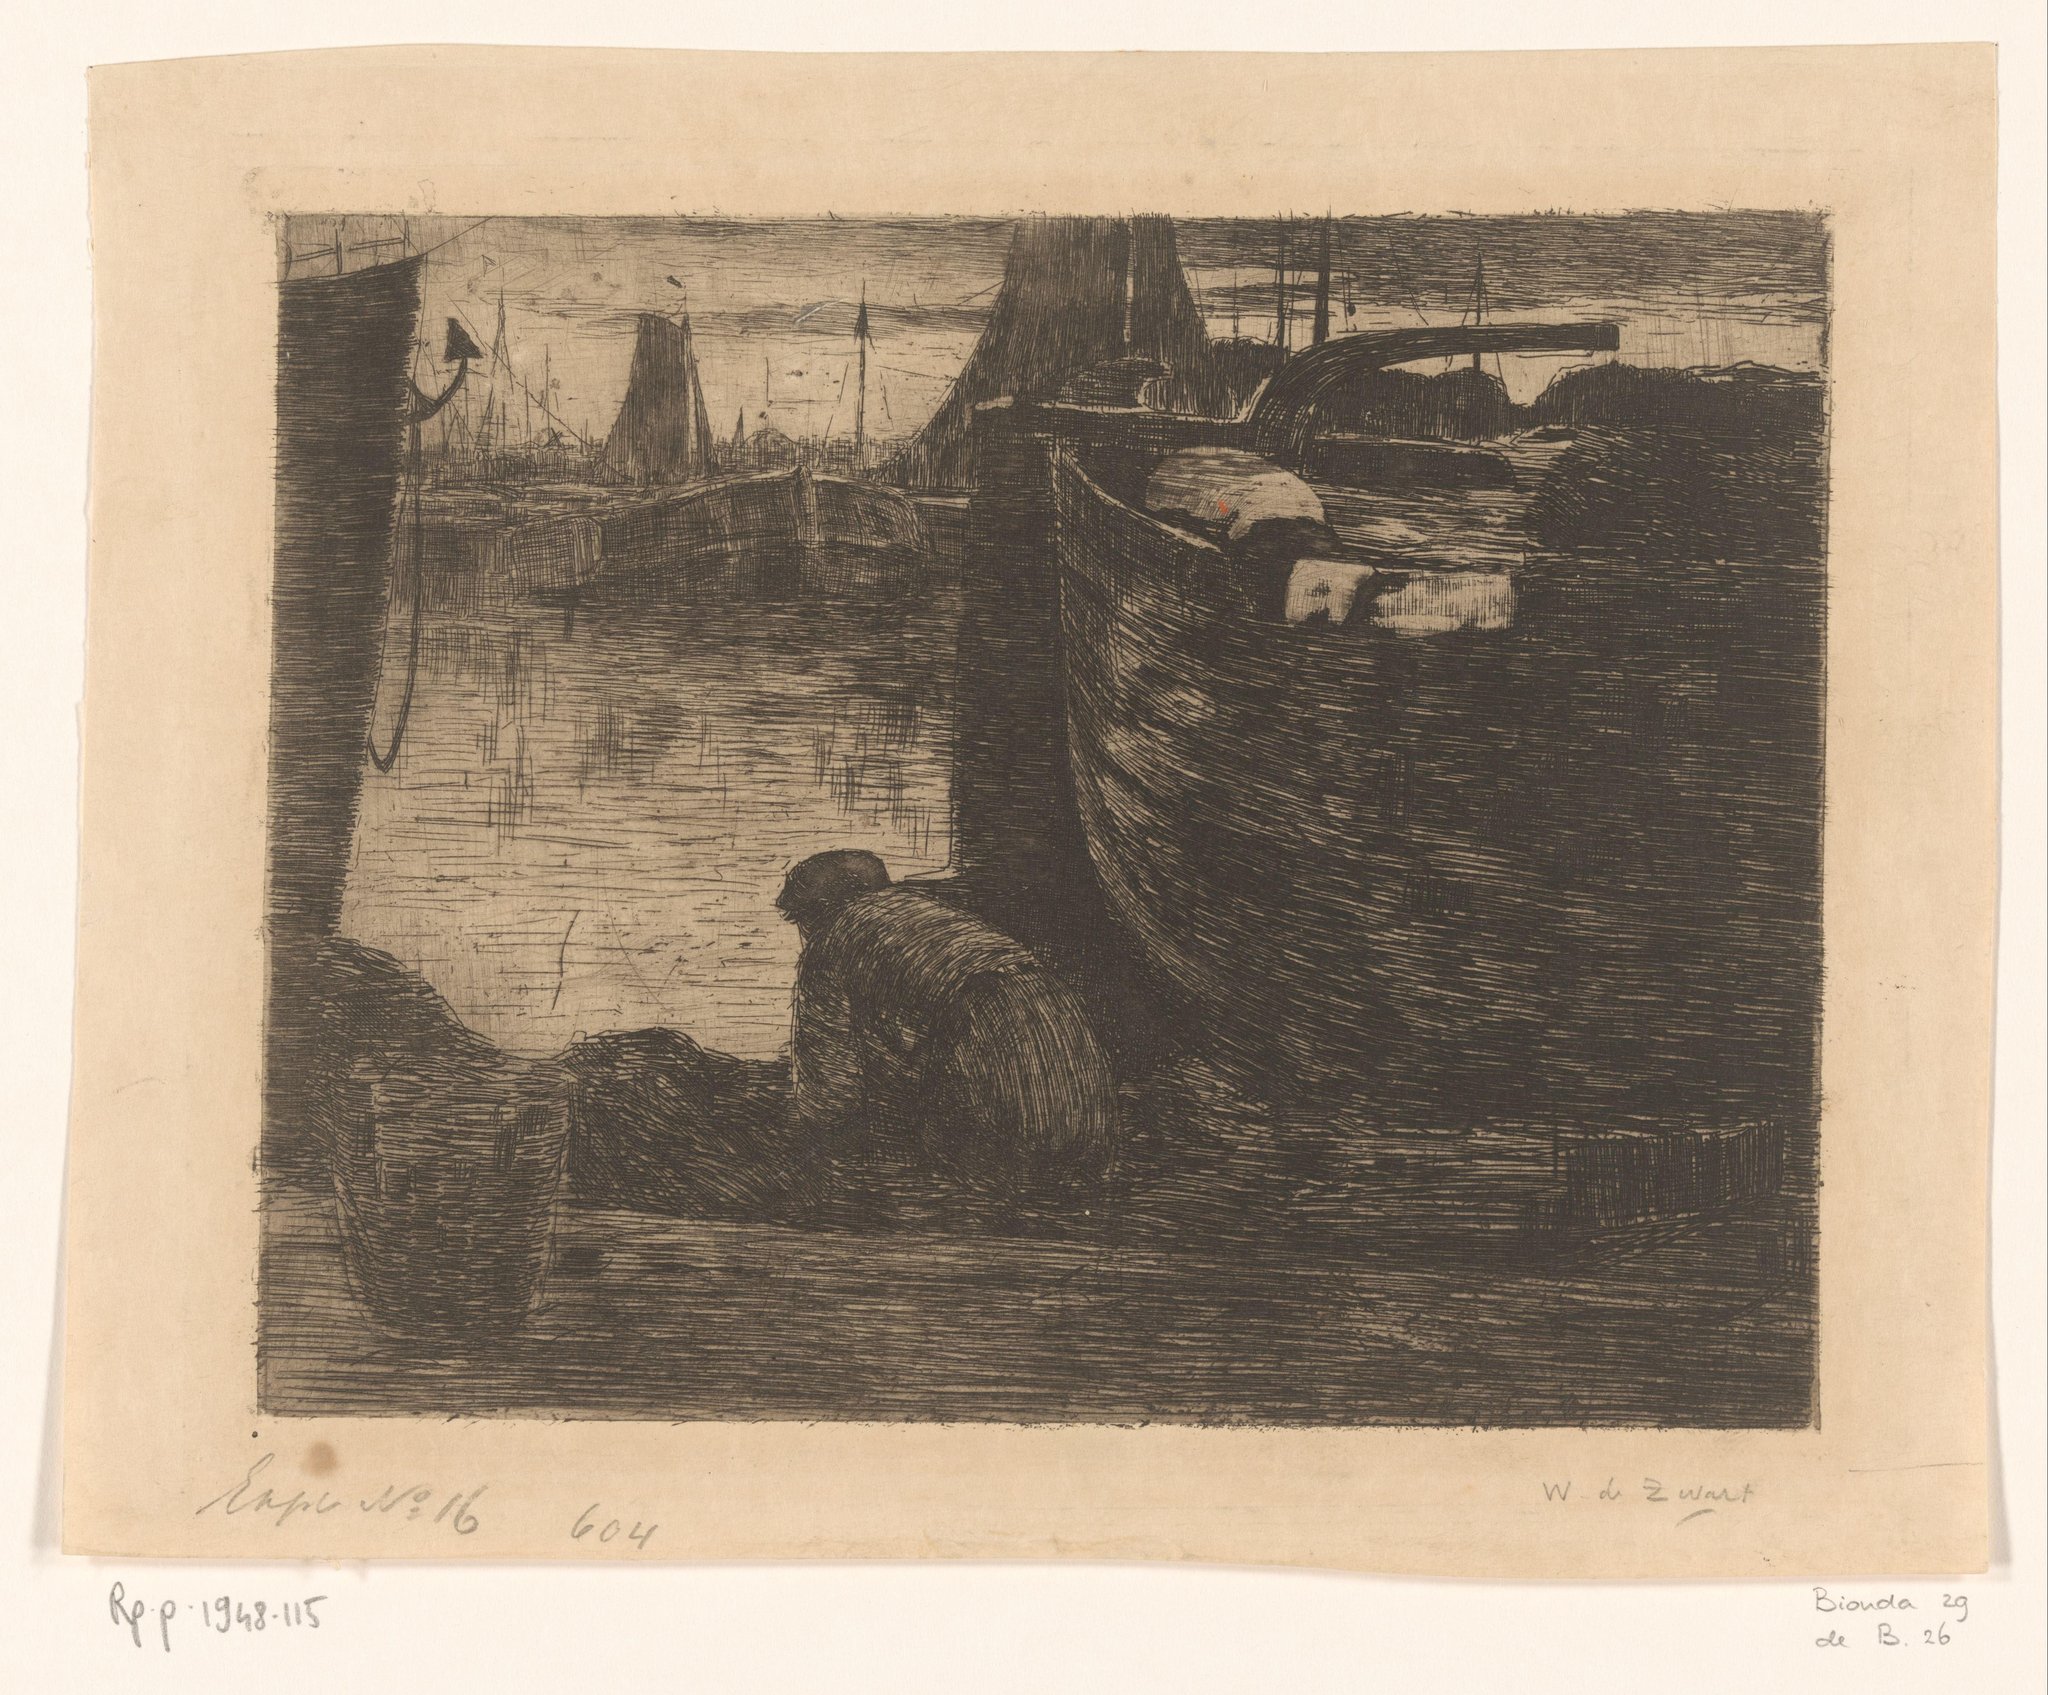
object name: print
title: Man aan de kade van een haven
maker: willem de zwart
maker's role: draughtsman, painter, print maker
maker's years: 1862-1931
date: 1886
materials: paper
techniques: drypoint, etching, intaglio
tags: harbour, pier, quay, wharf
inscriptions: collector's mark: Lugt 2228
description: Prent verscheen in 1887 als onderdeel van de jaarlijkse uitgave van de 'Portefeuille der Nederlandsche Etsclub'.